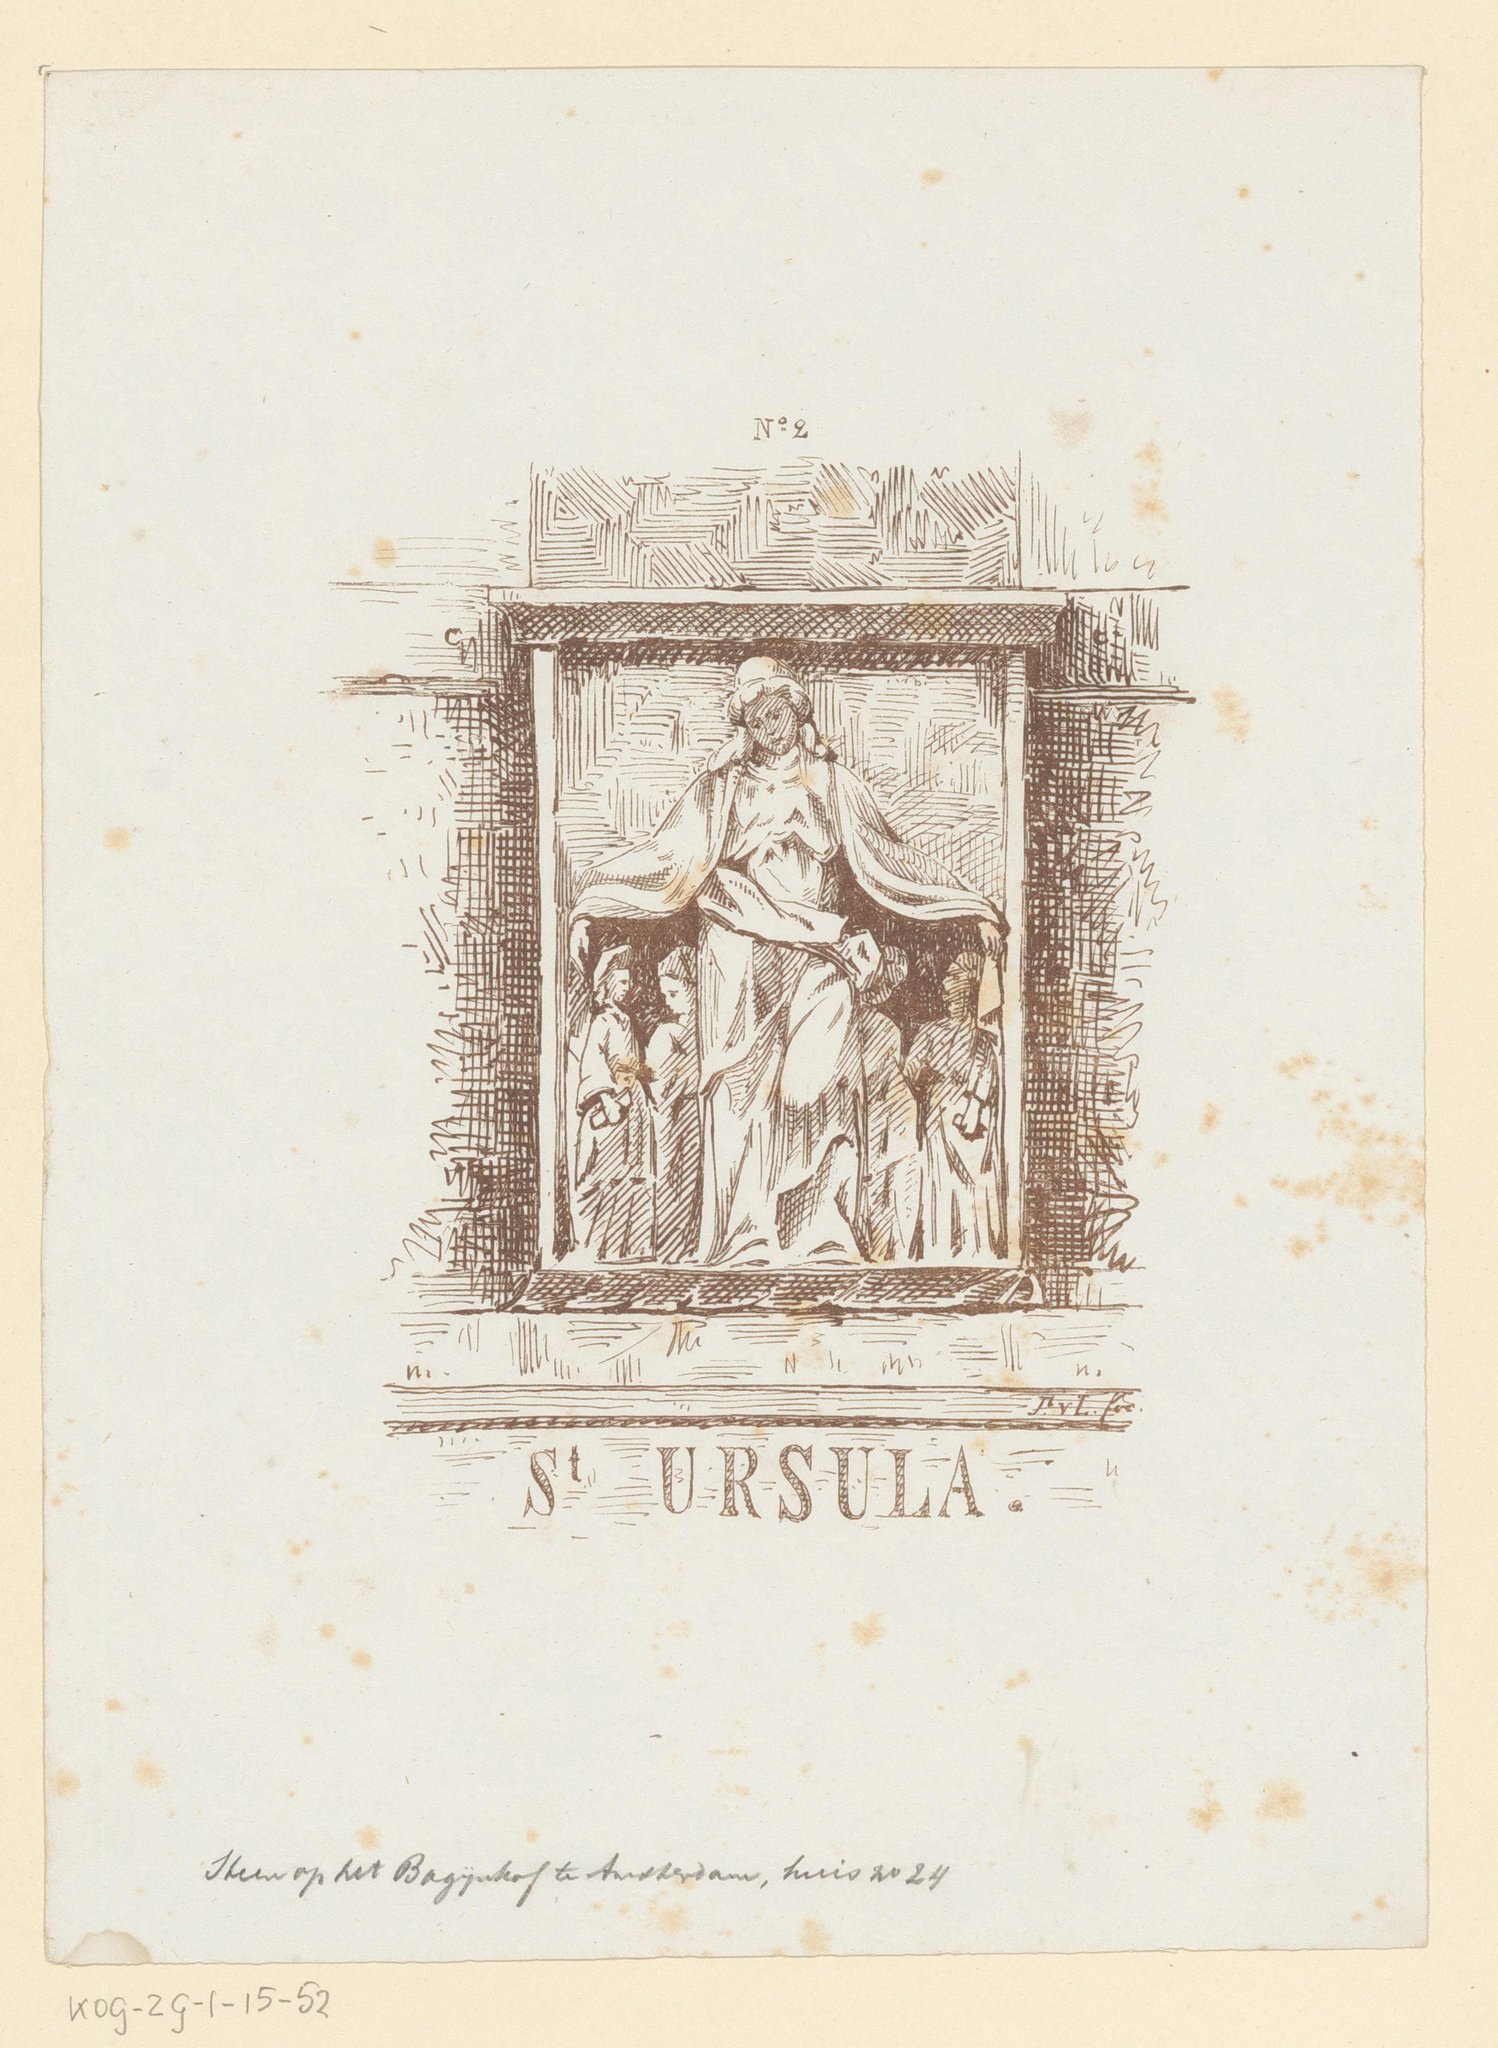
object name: print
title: Gevelsteen met de heilige Ursula Begijnhof in Amsterdam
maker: jac van looij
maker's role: draughtsman, painter, print maker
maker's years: 1855-1930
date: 1877-1894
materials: paper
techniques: lithograph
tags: stone tablet in façade, st. ursula protecting the eleven thousand virgins with her cloak, amsterdam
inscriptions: collector's mark: Lugt 1641, stamp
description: Gevelsteen met de heilige Ursula Begijnhof in Amsterdam. Genummerd midden boven: No. 2. Onderwerpsrubrieken binnen de Atlas Zeden en Gewoonten: Handel, nijverheid en verkeer, Uithangteekens, gevelstenen.